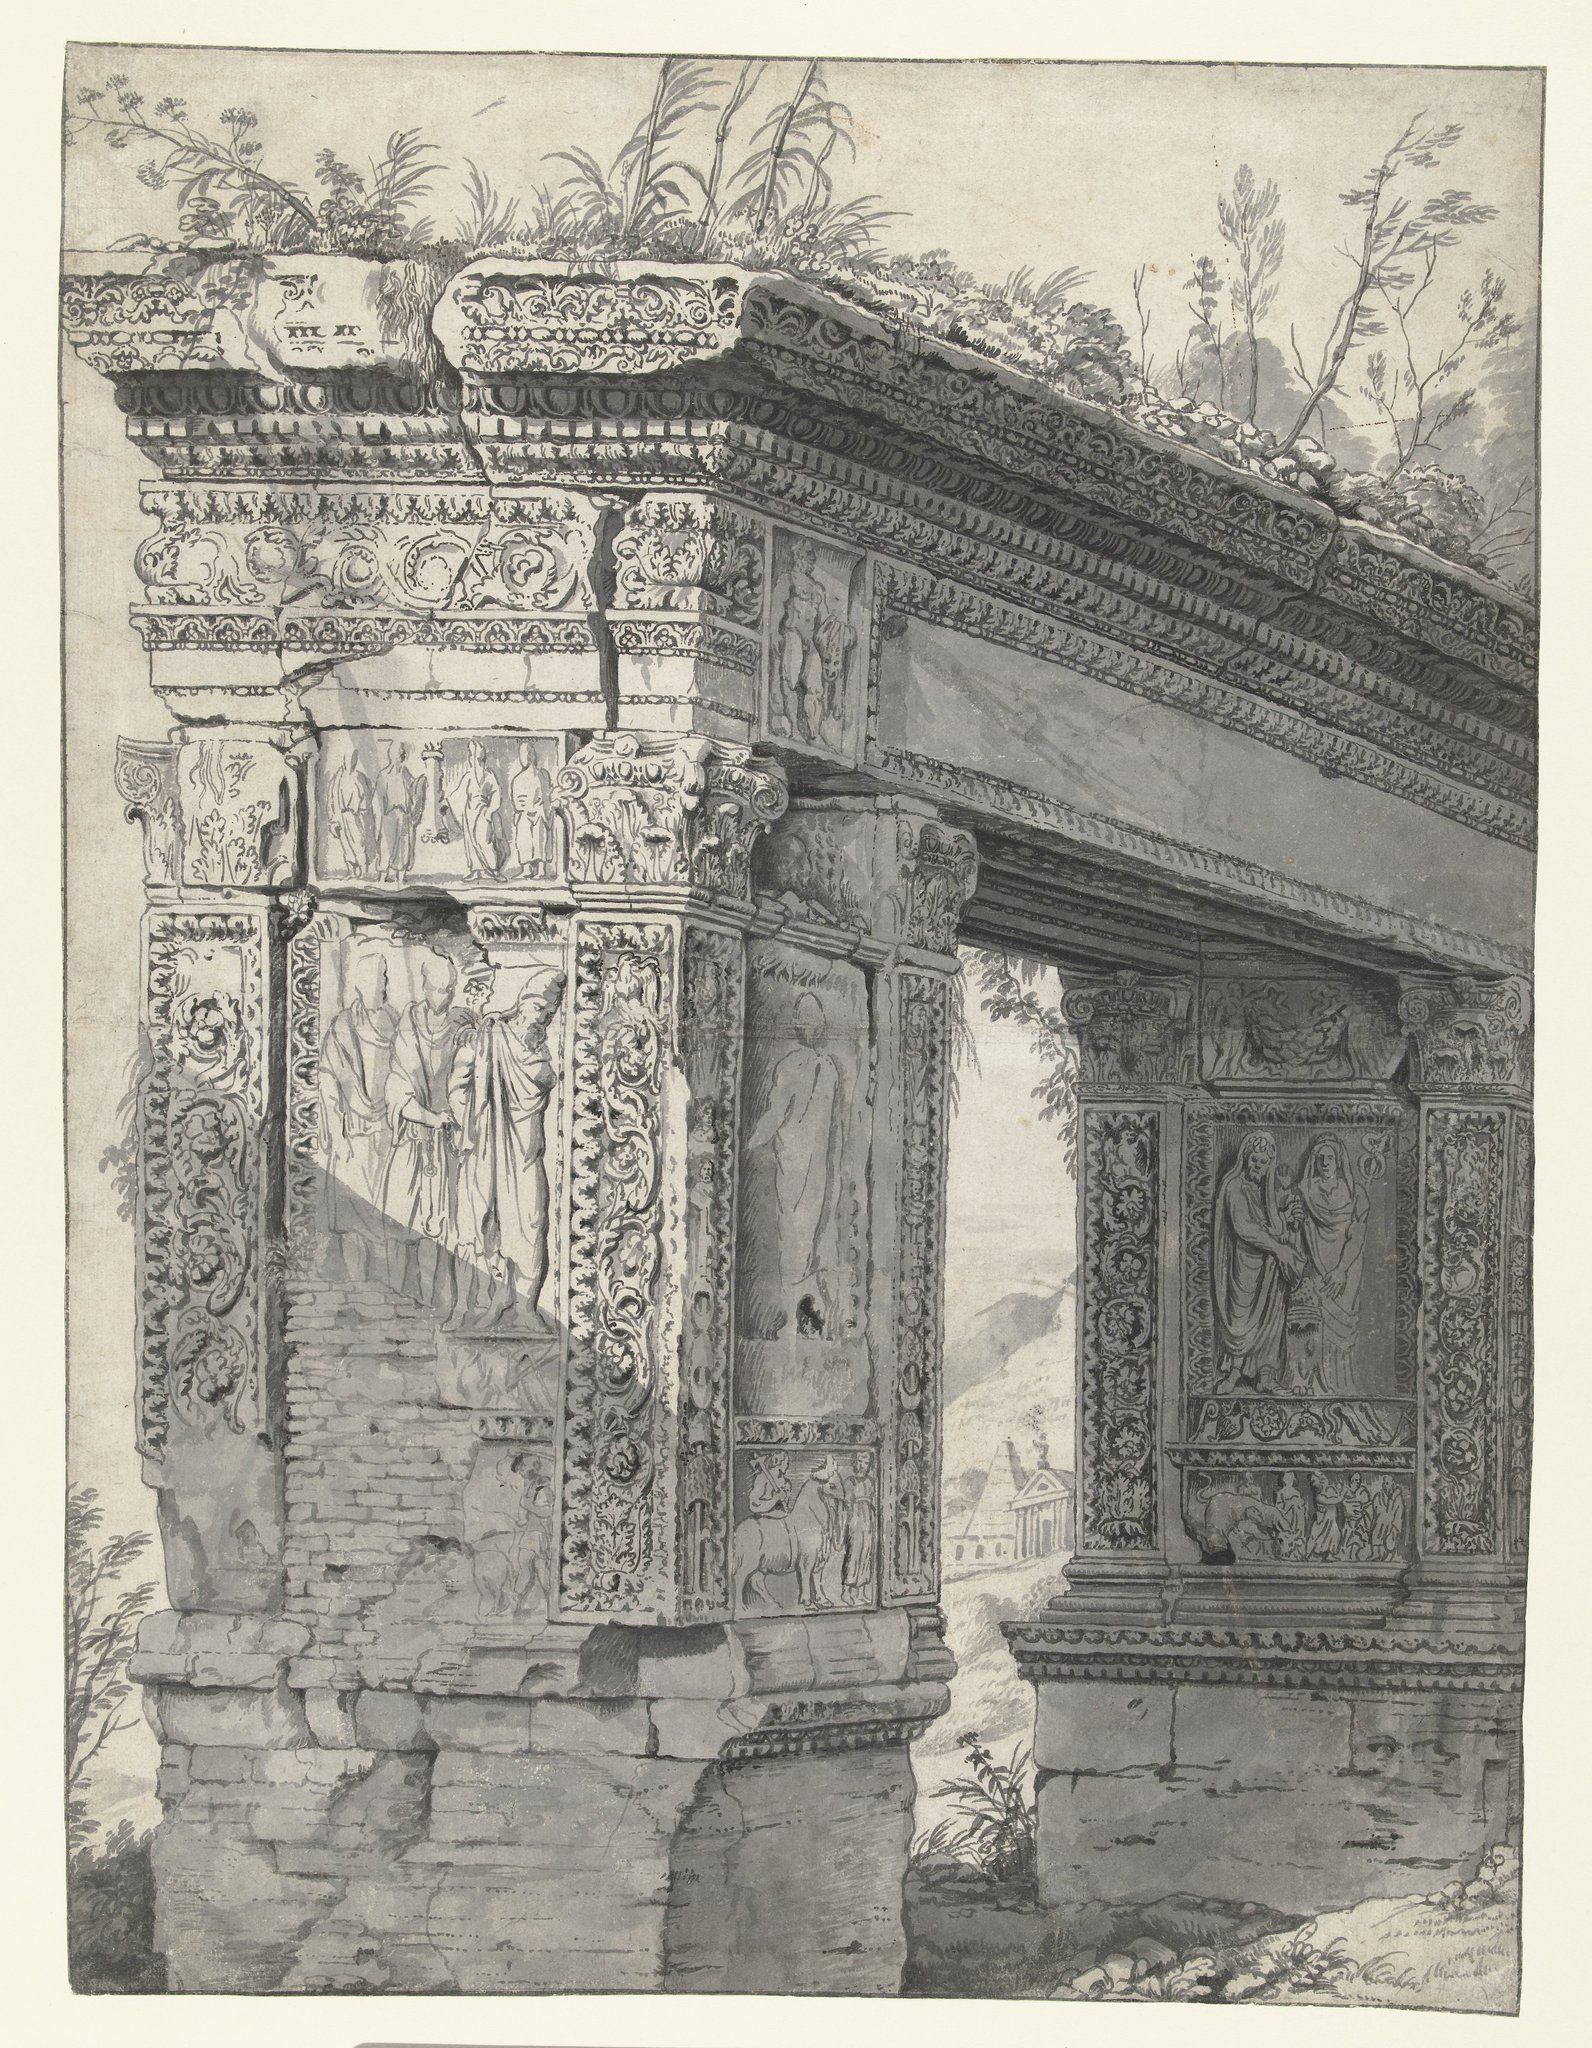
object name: drawing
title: Romeinse triomfboog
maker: willem romeyn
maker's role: draughtsman, painter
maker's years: 1624-1694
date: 1634-1694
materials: paper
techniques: brush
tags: triumphal arch, representation of real building (either existing or having existed) (+ roman art), italy